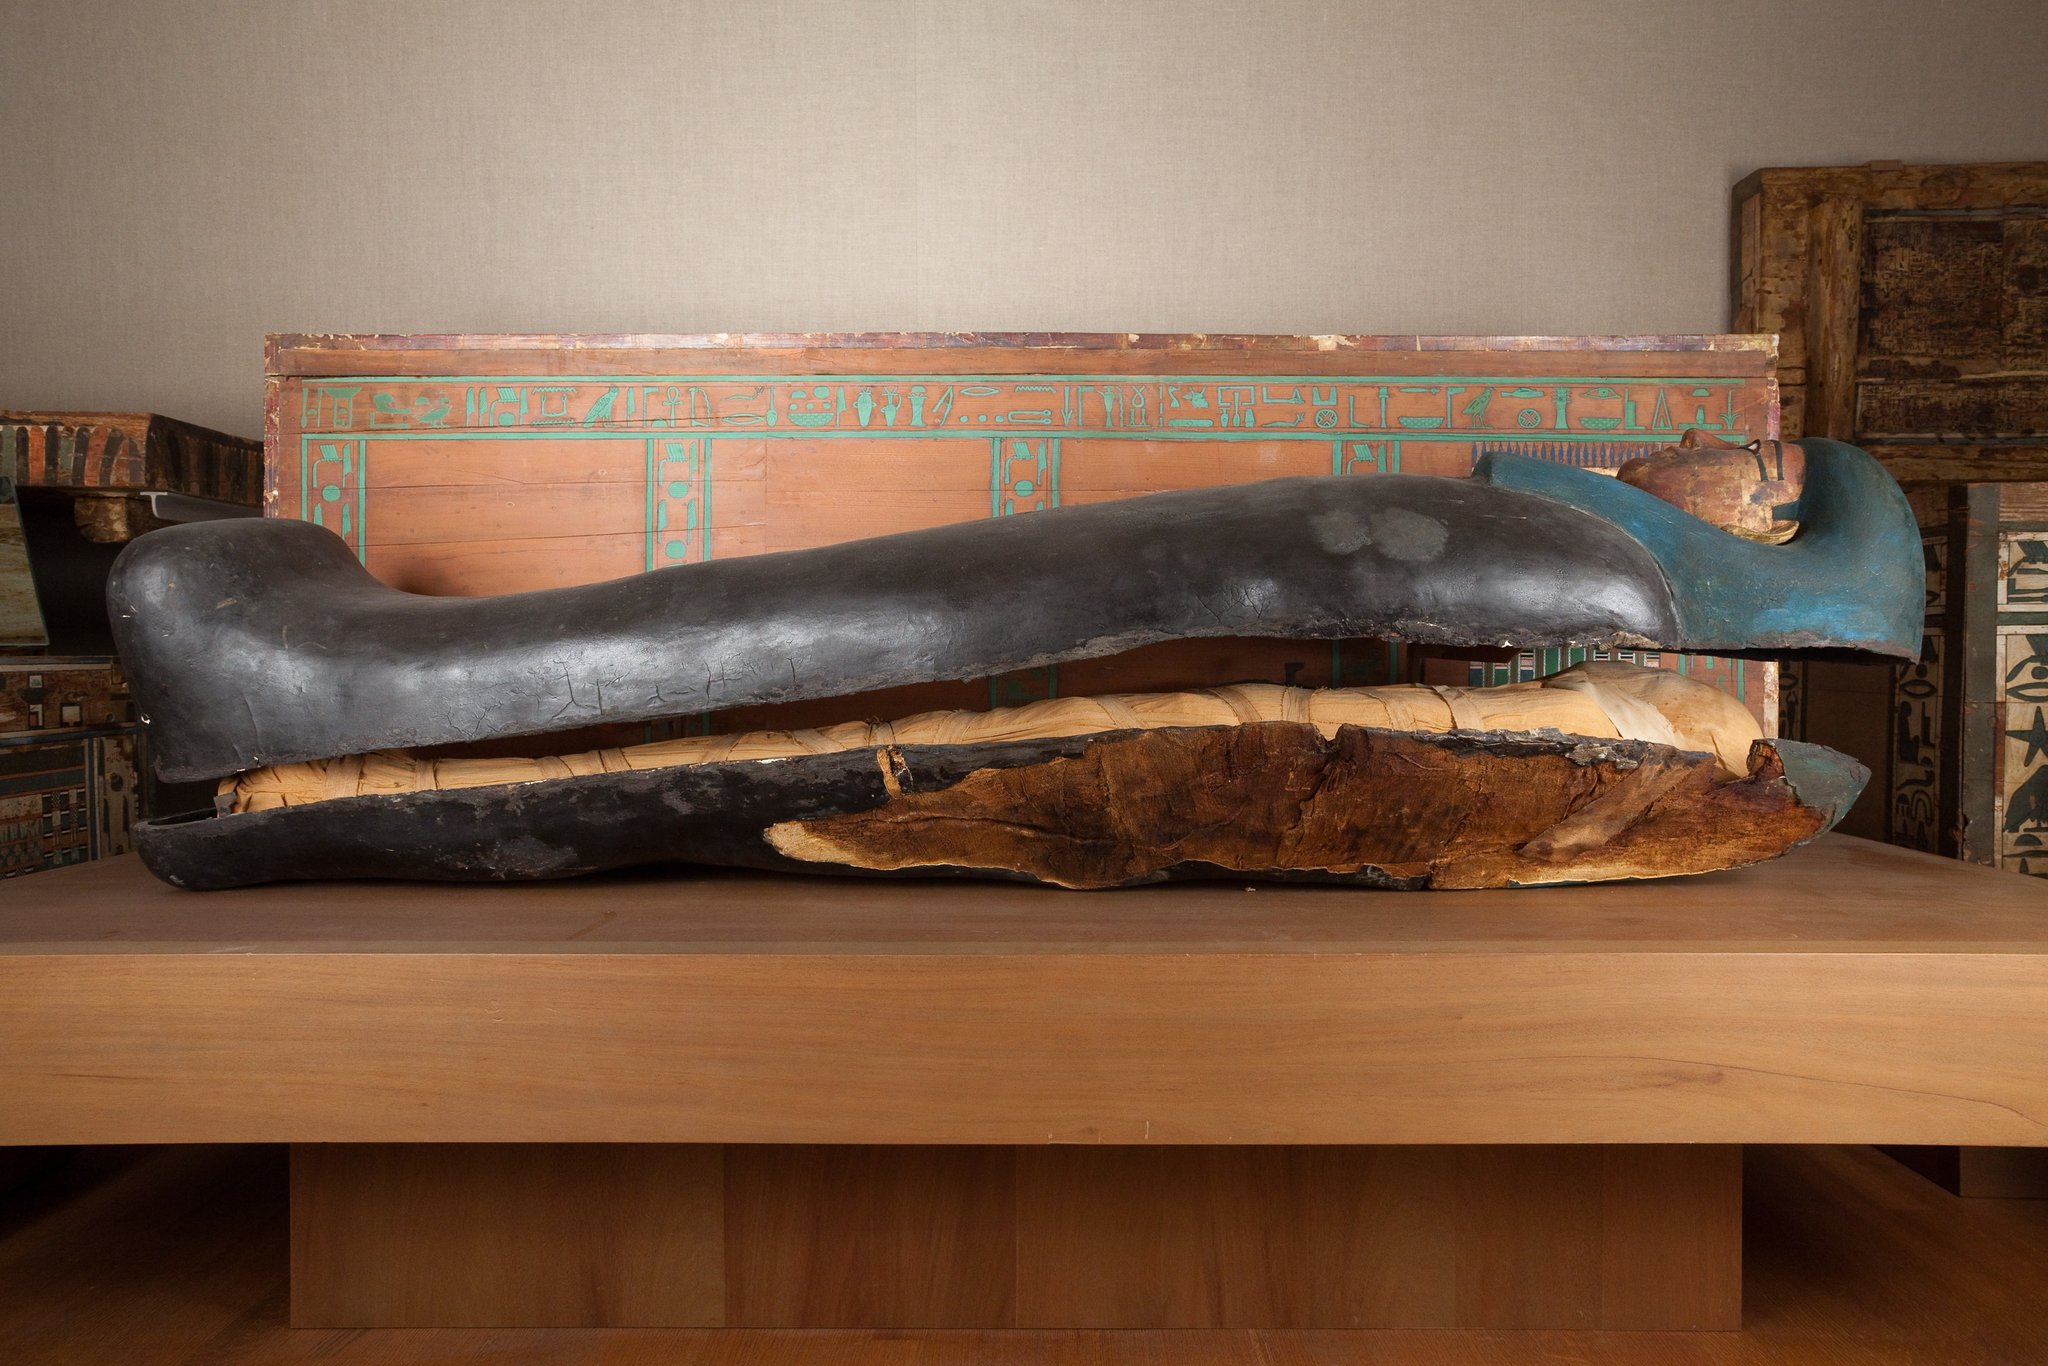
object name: mummy, nephthys, human remains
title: Mummy of a woman named Nephthys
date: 1961-1878 BCE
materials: linen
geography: egypt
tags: mummies